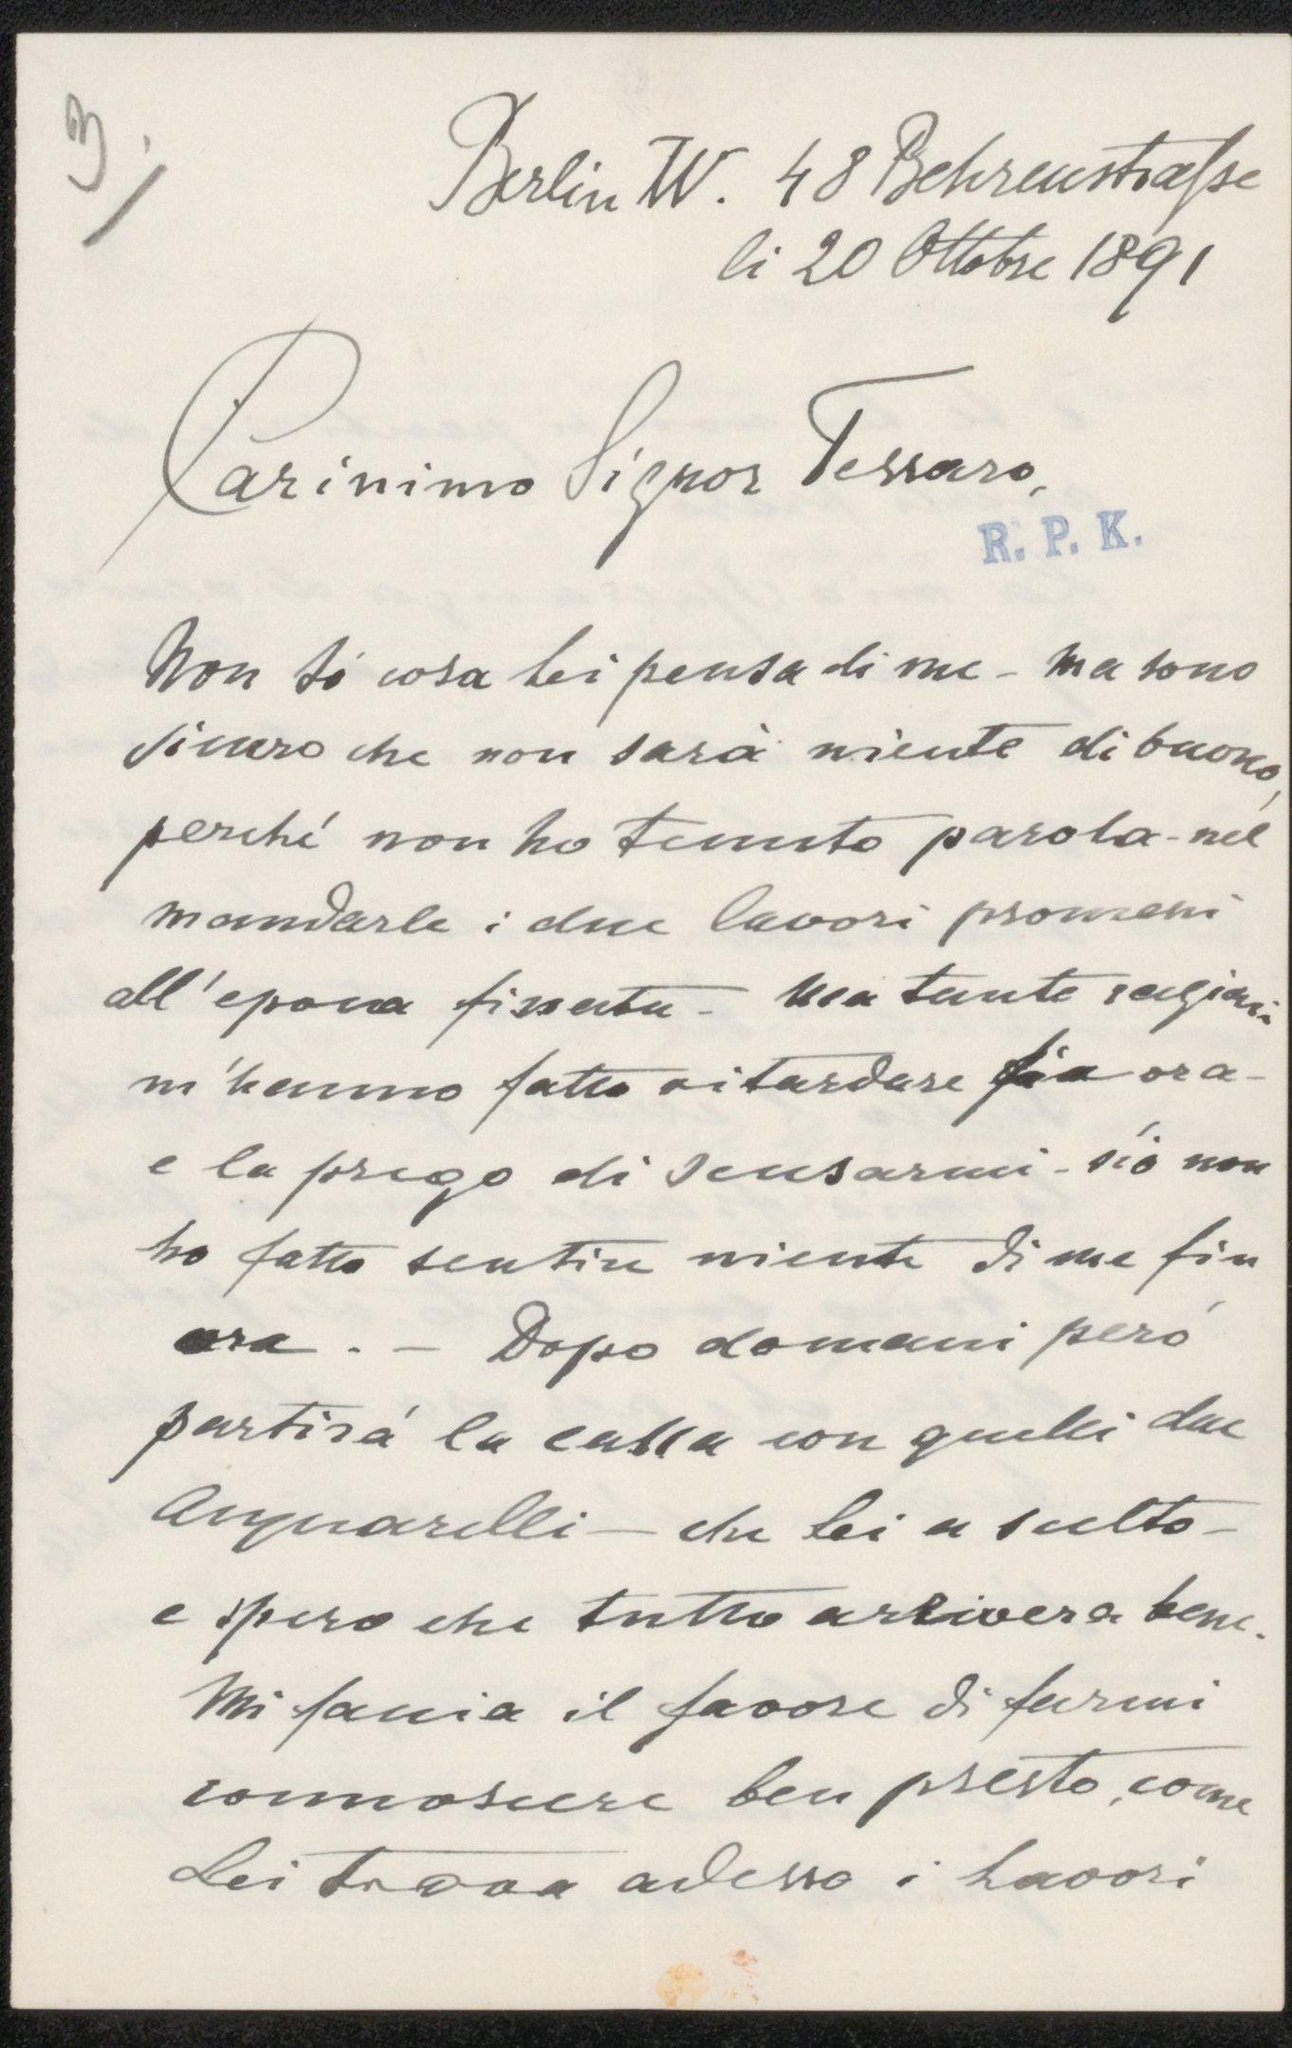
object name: letter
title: Brief aan Filippo Tessaro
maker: ludwig johann passini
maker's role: painter, print maker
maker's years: 1832-1903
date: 1891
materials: ink, paper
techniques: pen, writing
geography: berlin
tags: drawing, diseases, money, venice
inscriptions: collector's mark: Lugt 2233, watermark